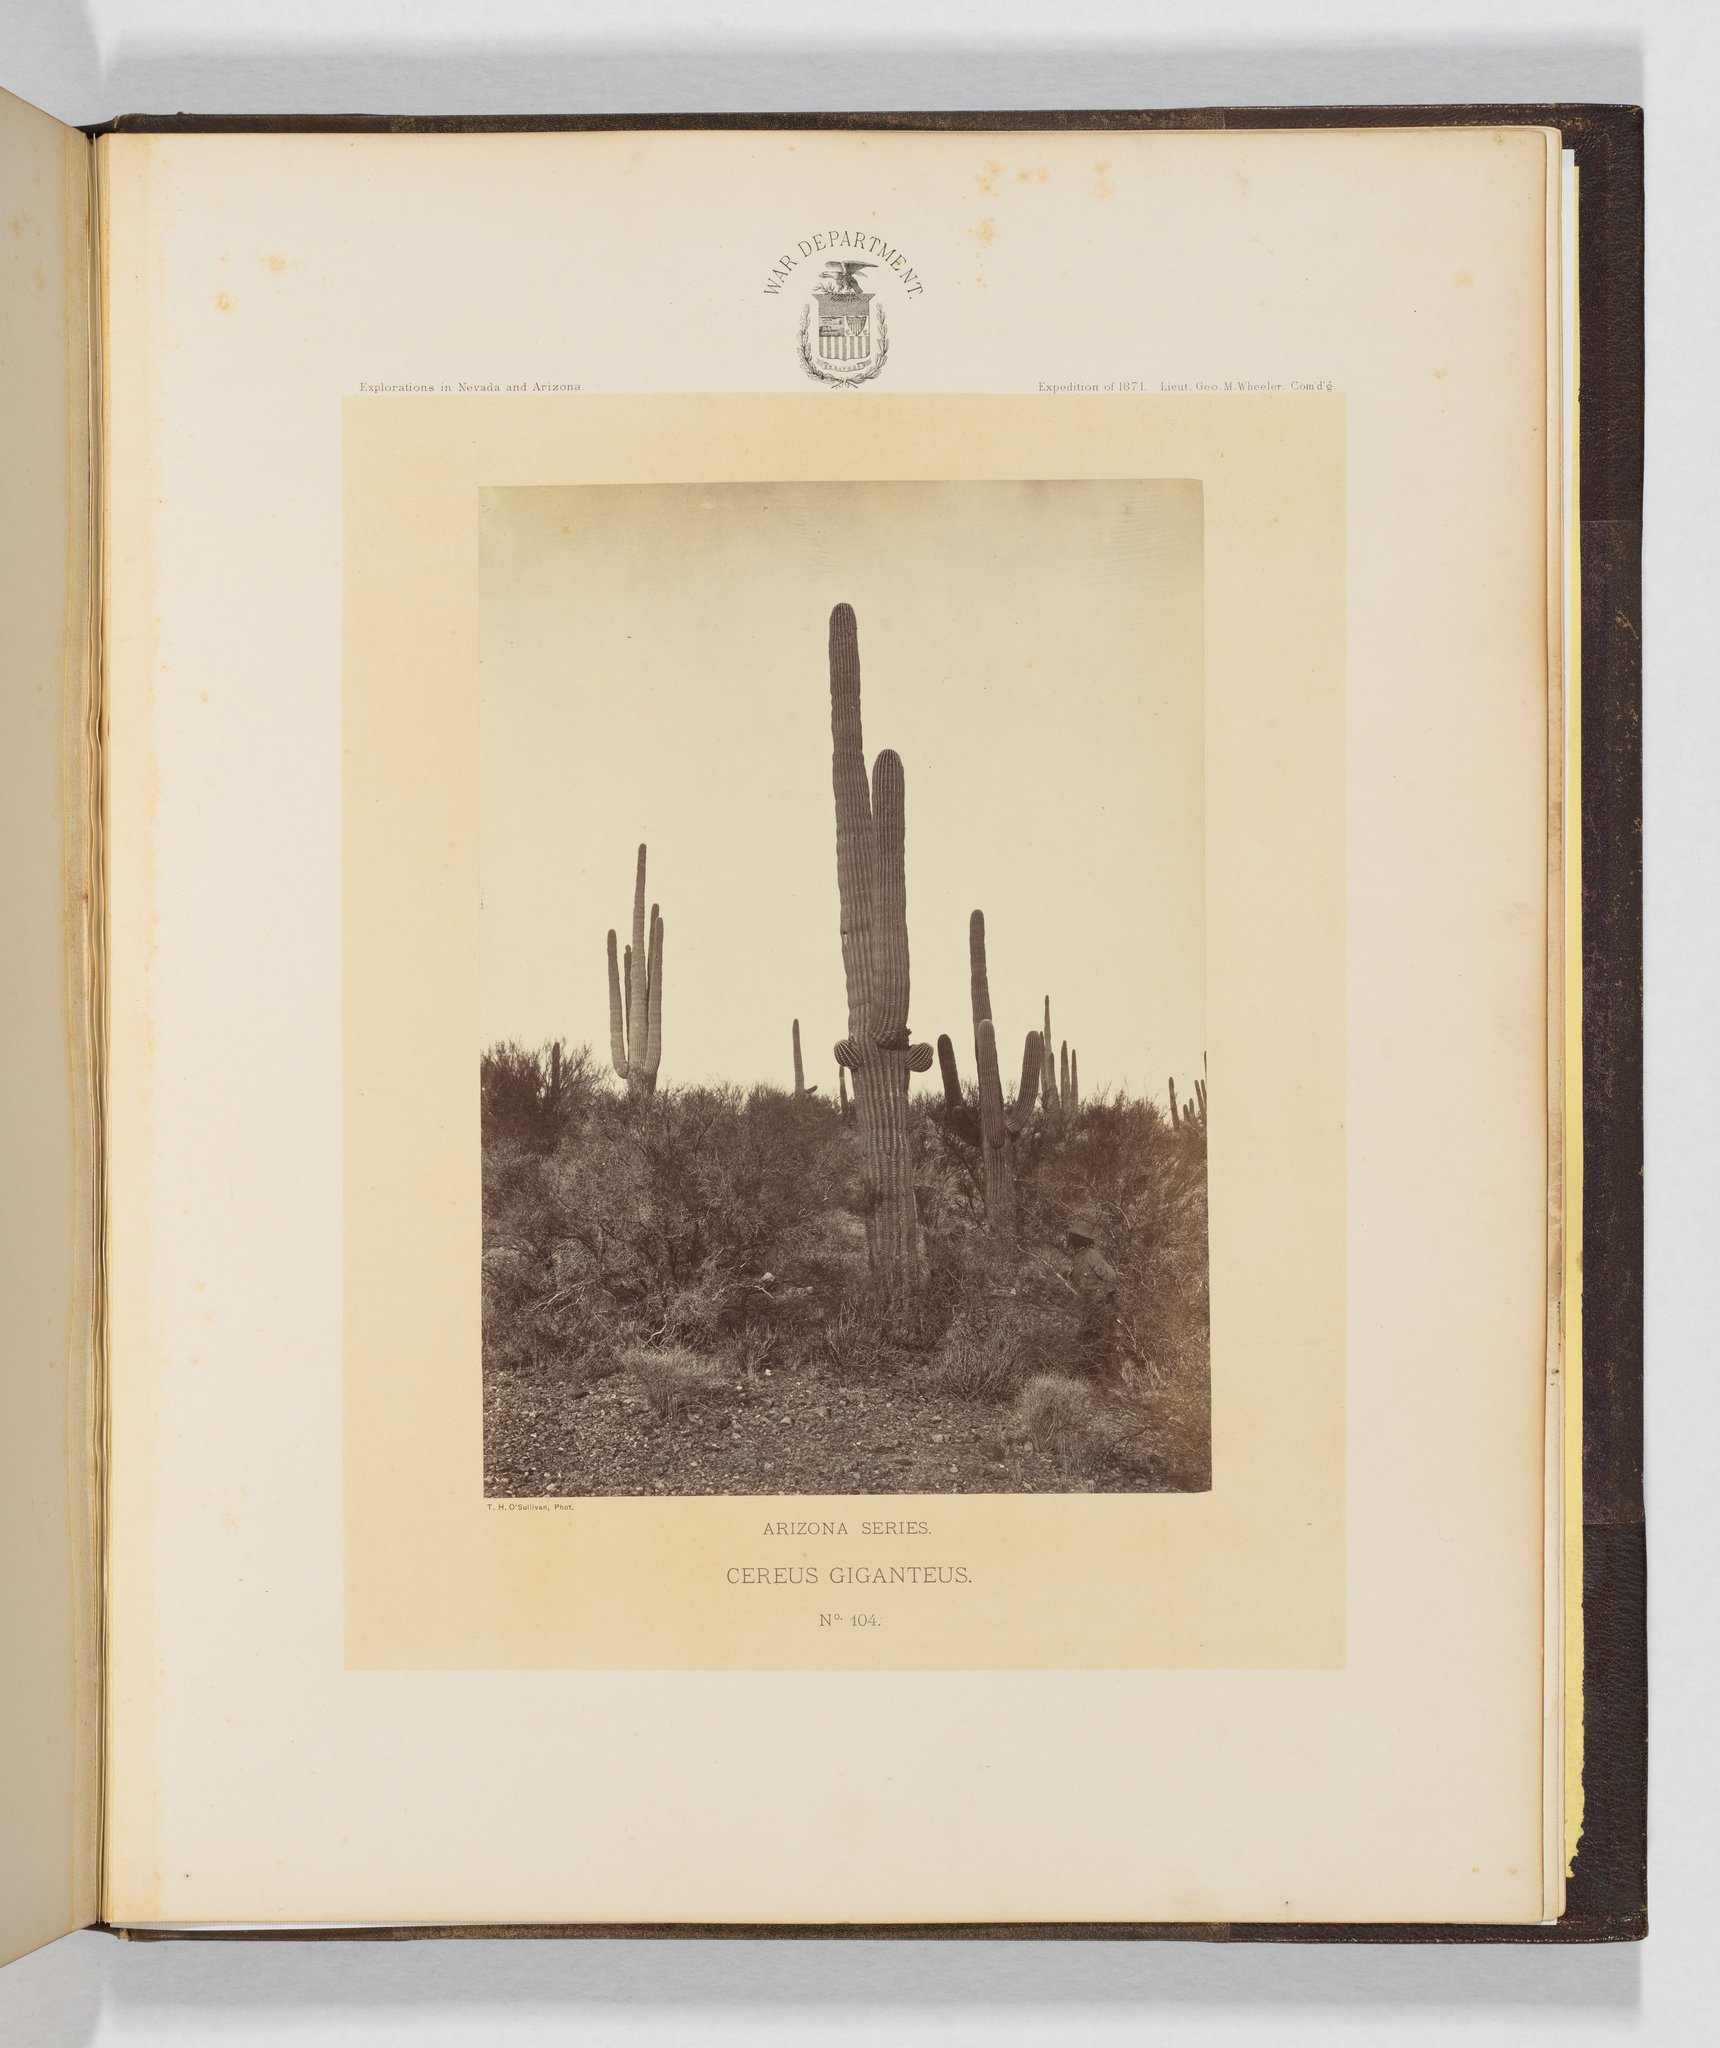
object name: photograph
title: Cereus Giganteus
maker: timothy h. o'sullivan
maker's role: artist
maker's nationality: american, born ireland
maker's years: 1840-1882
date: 1871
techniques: albumen silver print, glass negative